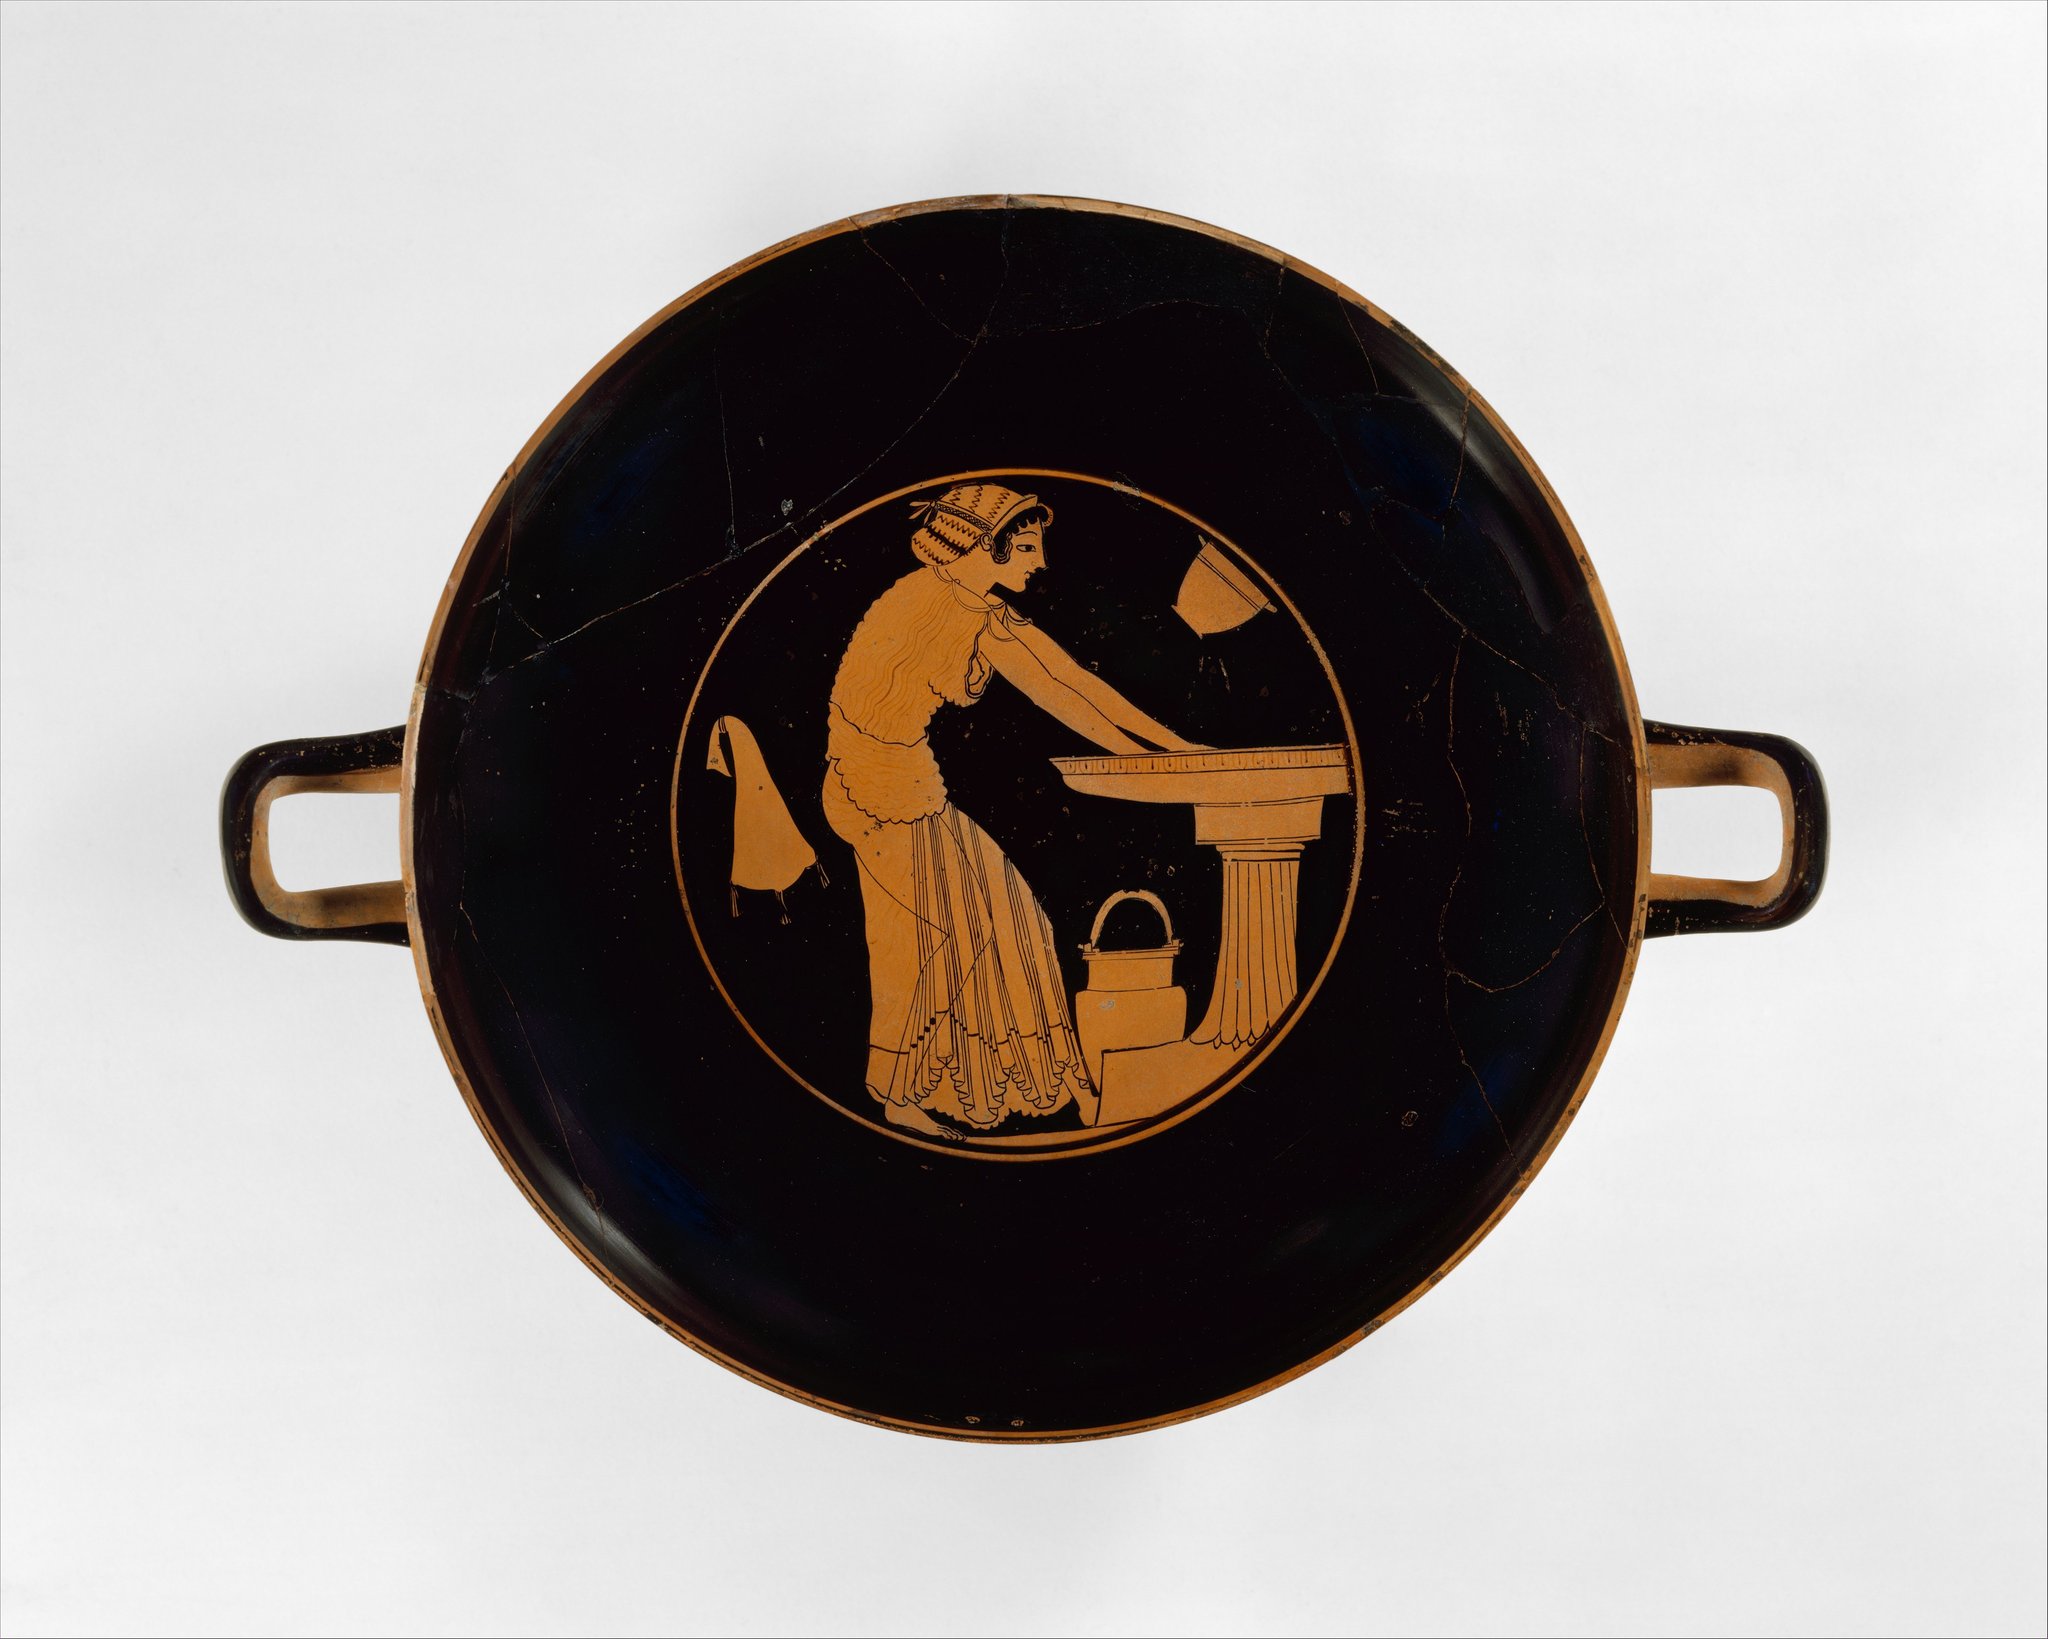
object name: kylix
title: Terracotta kylix (drinking cup)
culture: greek, attic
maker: douris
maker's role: artist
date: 500 BCE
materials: terracotta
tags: male nudes,women,athletes